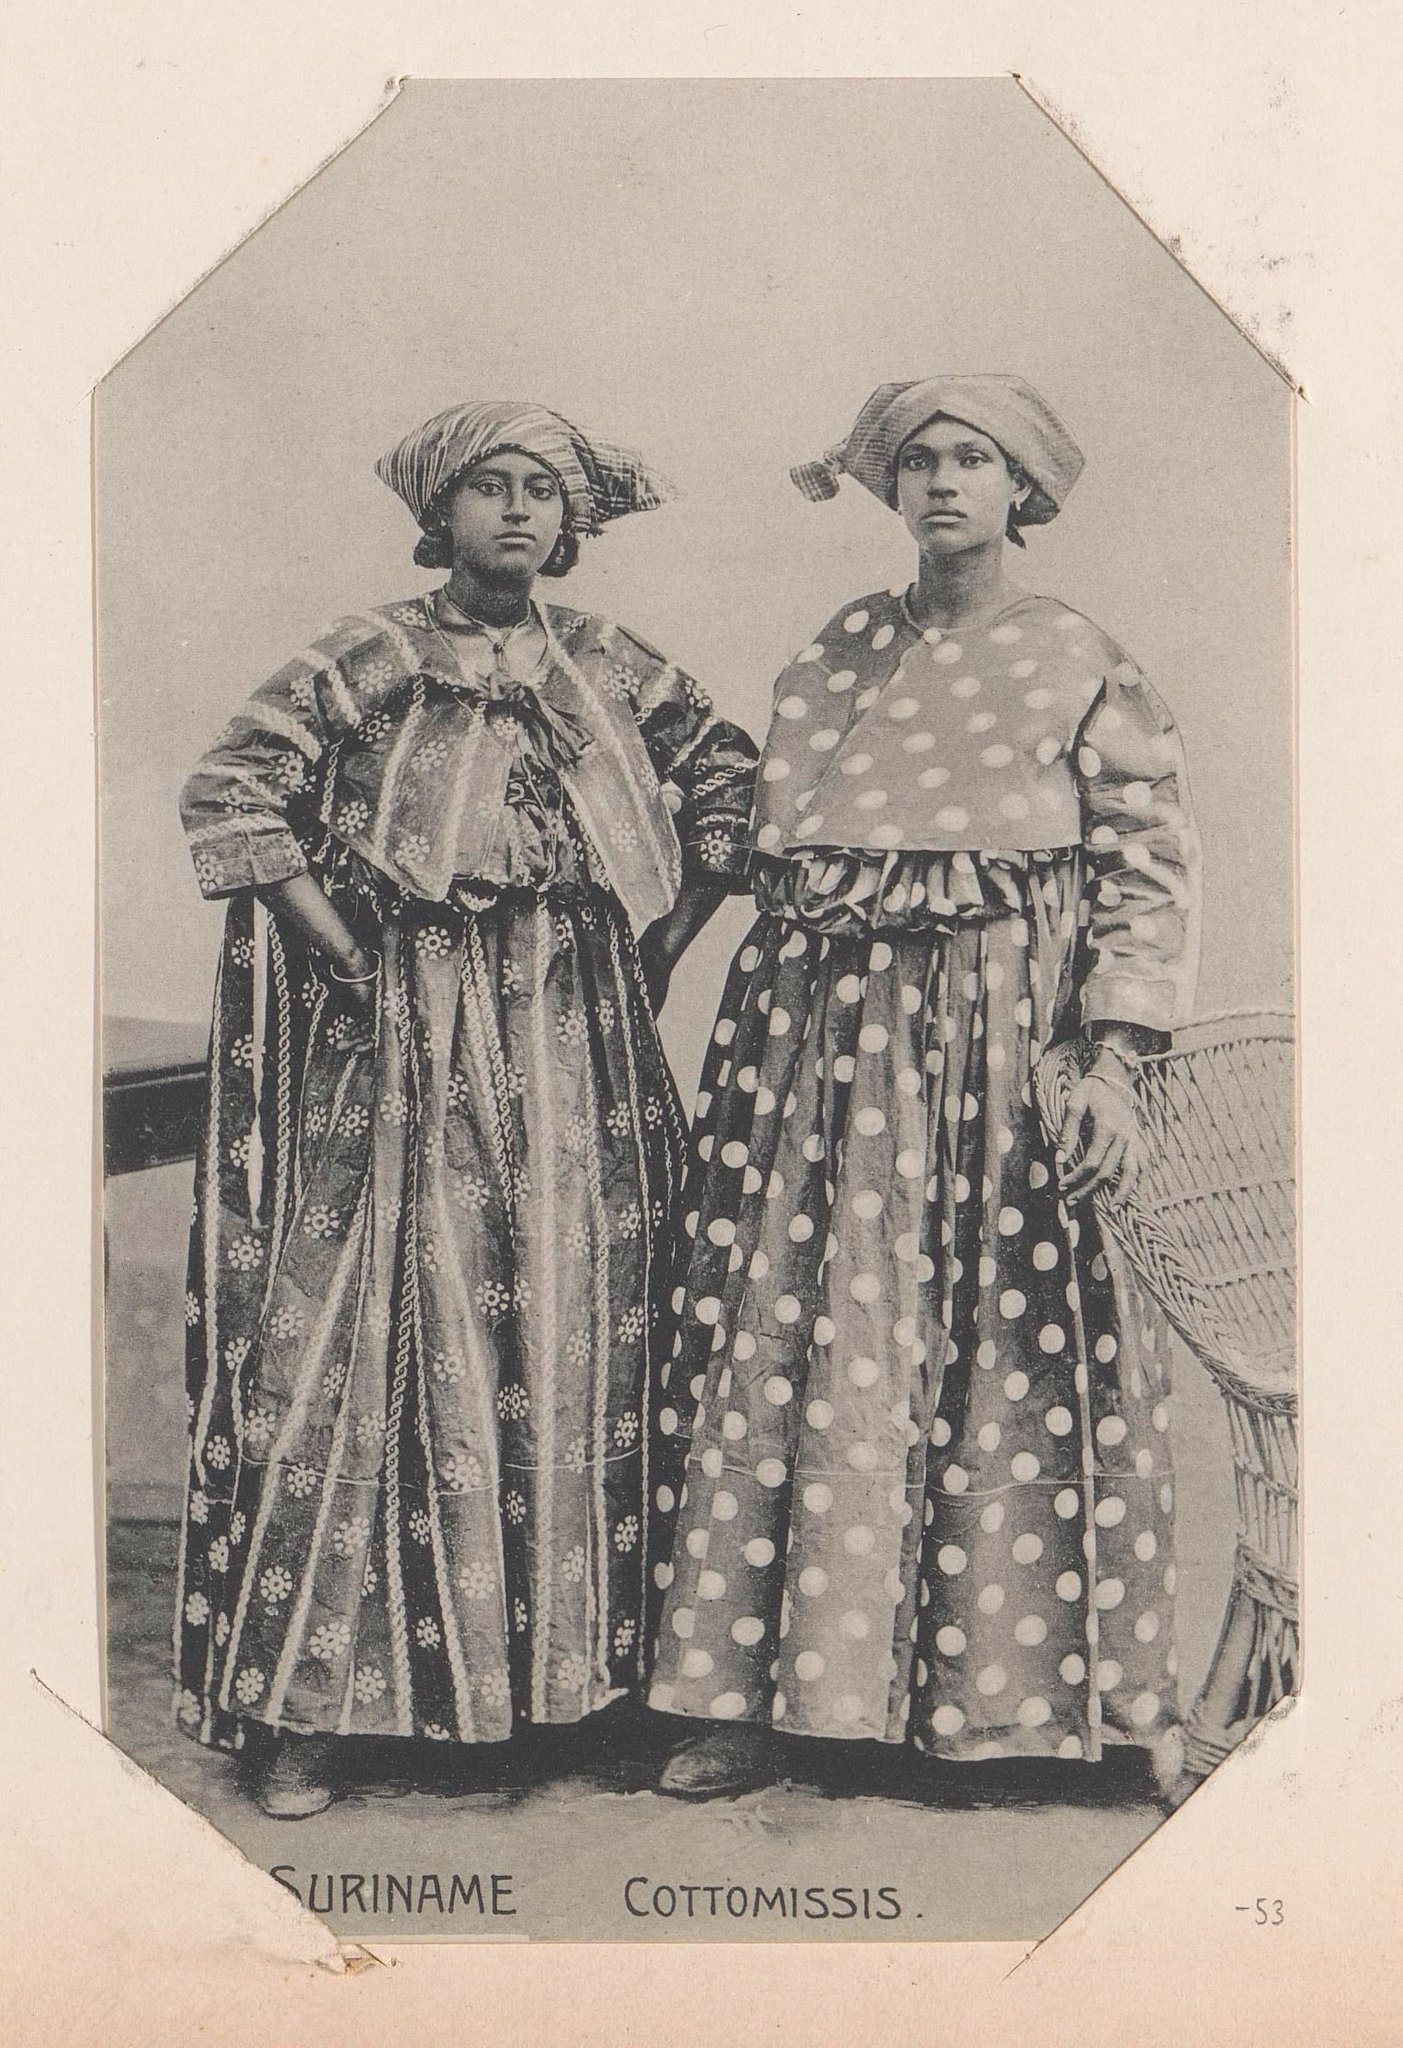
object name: ansichtkaart, prentbriefkaart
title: Surinaamse vrouwen in koto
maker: eugen klein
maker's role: fotograaf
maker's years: 1869-1927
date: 1900-1910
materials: cardboard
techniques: photograph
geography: suriname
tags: folk costume, regional costume, standing figure - aa - female human figure, suriname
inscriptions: serial number: ‘Eigendom van Eugen Klein, Paramaribo No. 191’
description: Portret van twee Surinaamse vrouwen in koto (kotomisi's). Onderdeel van een verzameling van 68 briefkaarten uit Suriname, bijeengebracht in een album als aandenken aan een verblijf in Suriname in september 1911.